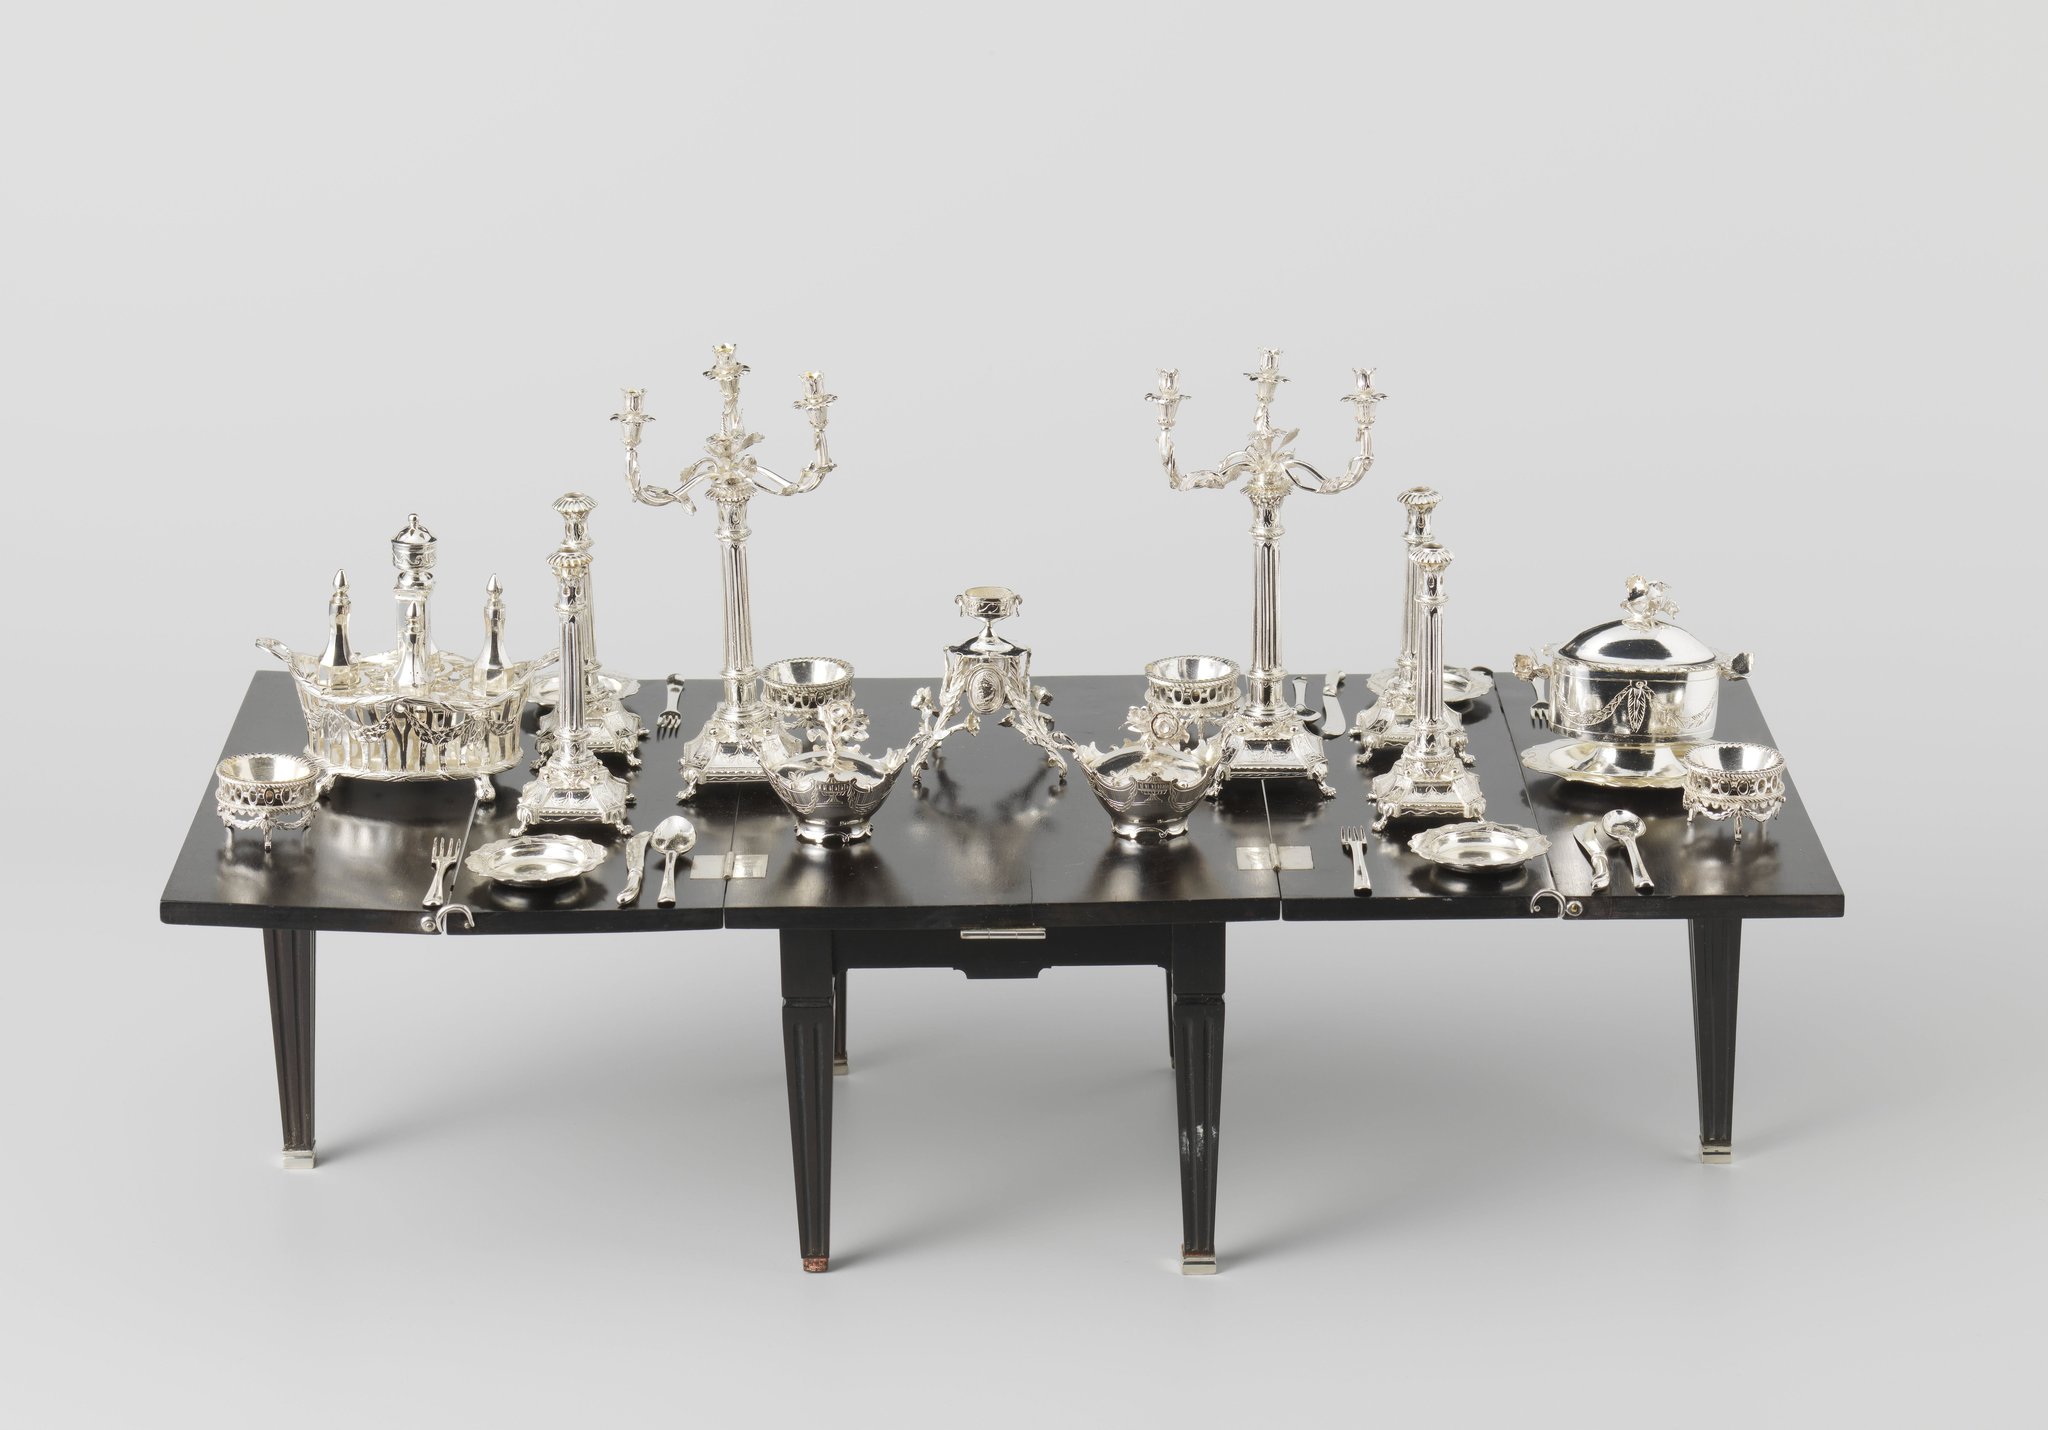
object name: miniature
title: Mes met pistoolvormig heft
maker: Anonymous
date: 1775-1800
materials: silver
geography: netherlands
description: Mes met pistoolvormig lemmet en pistoolvormig heft. Het mes is niet gemerkt. Het mes is gelijk aan vijf messen met de invnrs. BK-NM-11177-237, BK-NM-11177-239, BK-NM-11177-240, BK-NM-11177-241 en BK-NM-11177-242.